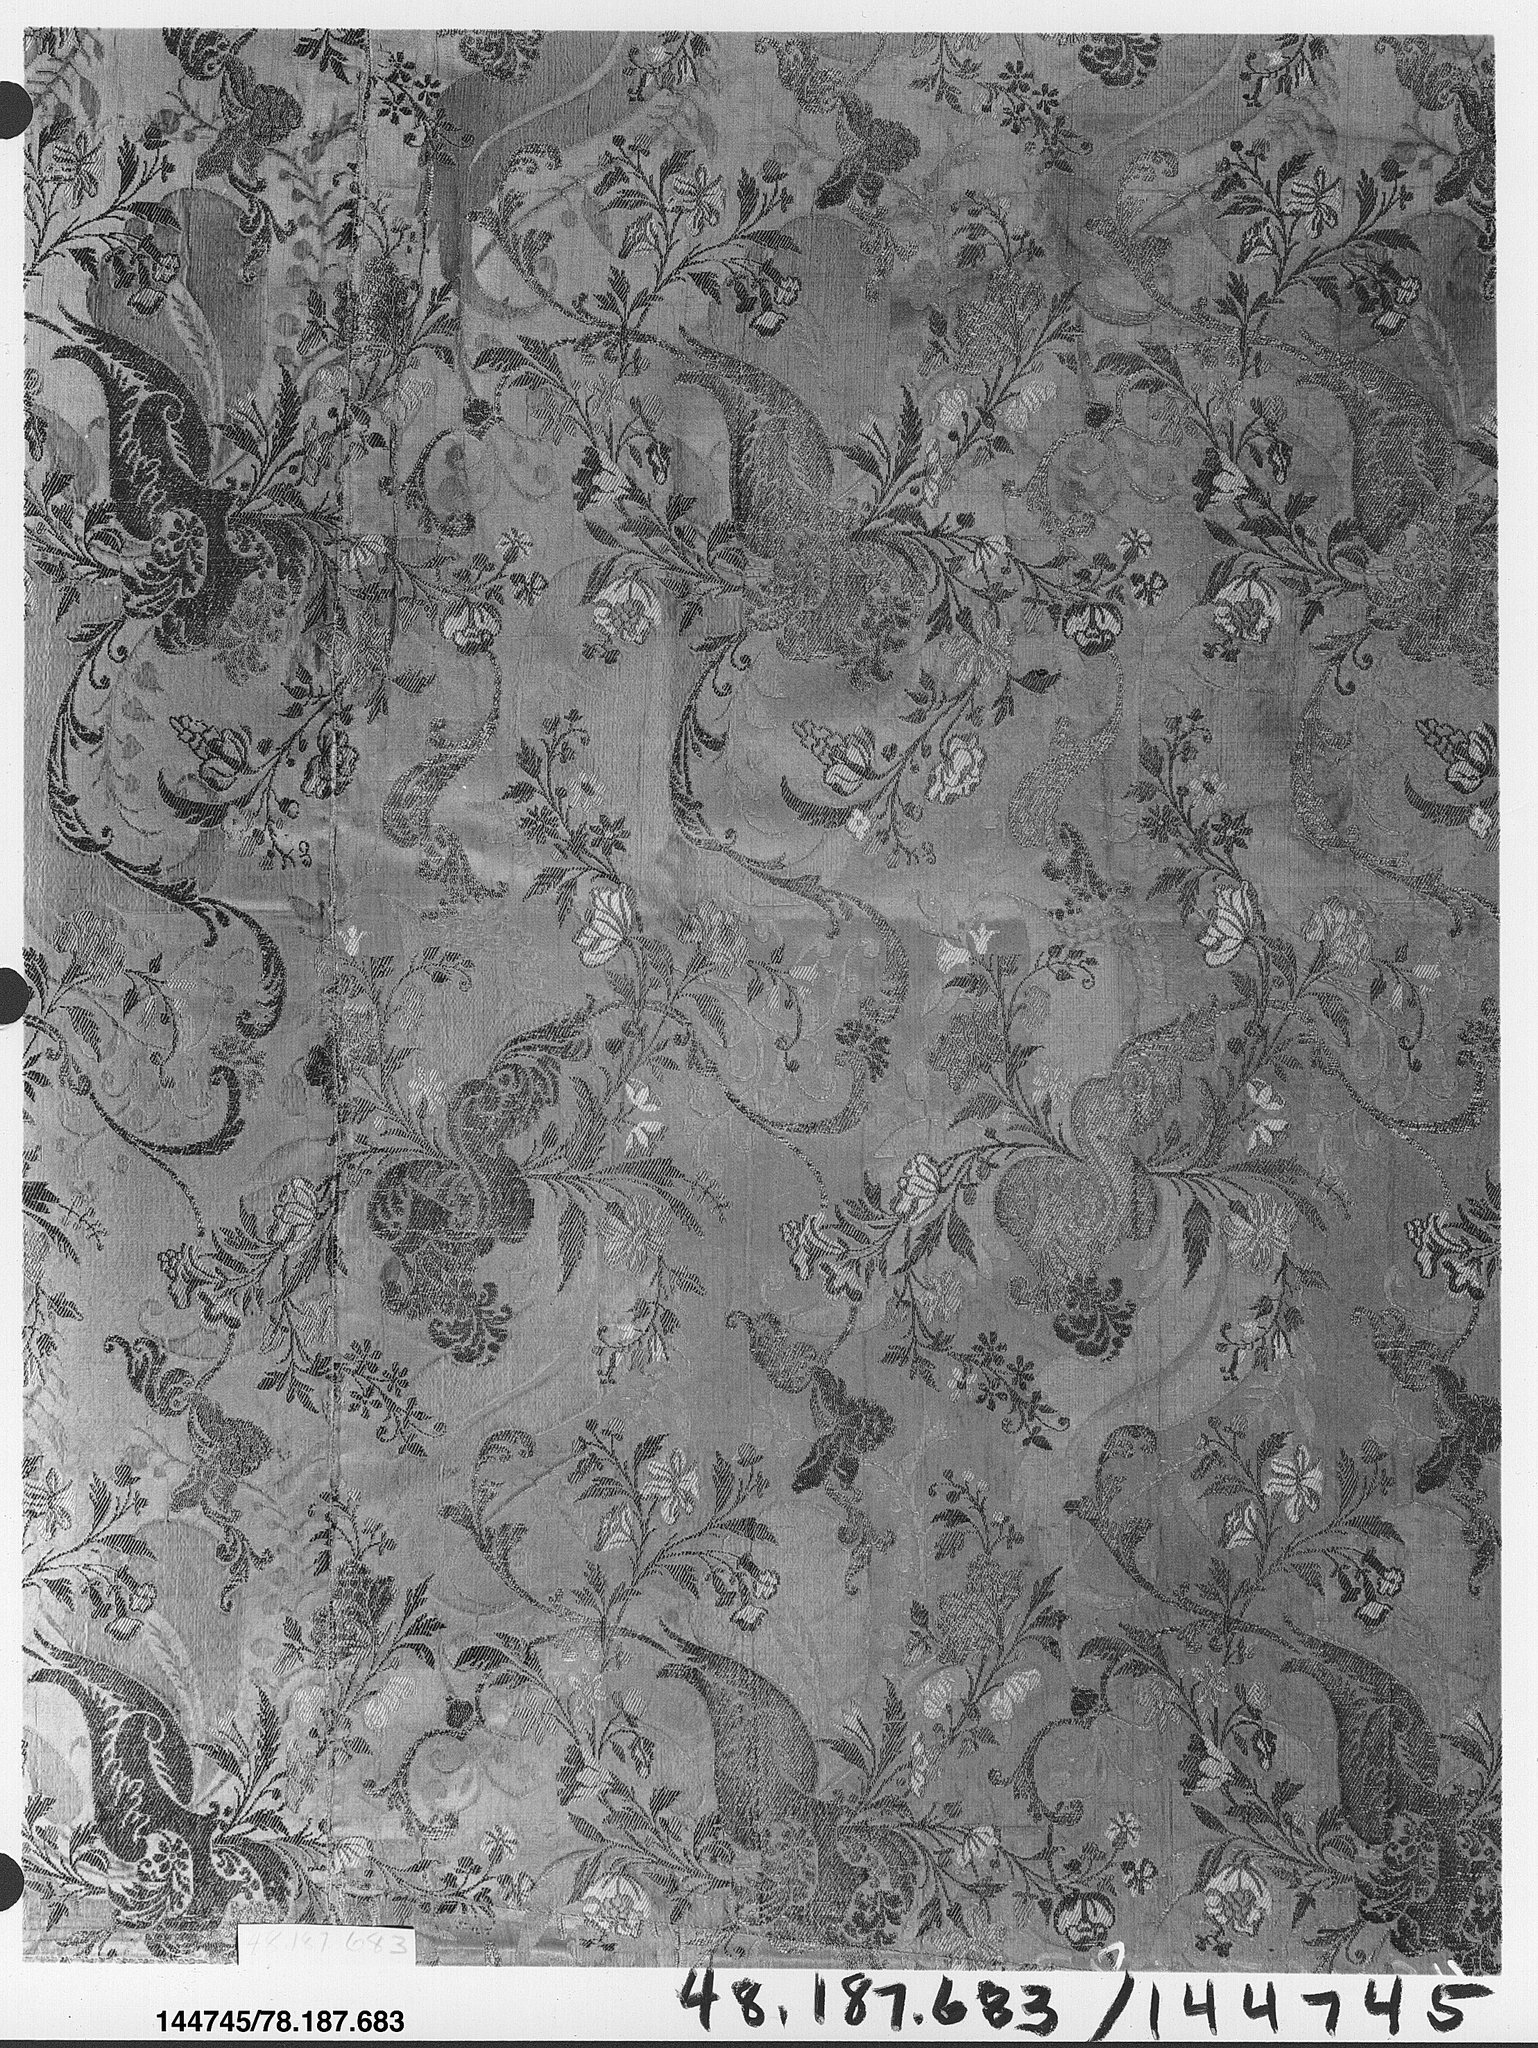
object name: piece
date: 1720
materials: metal thread, silk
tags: flowers,leaves